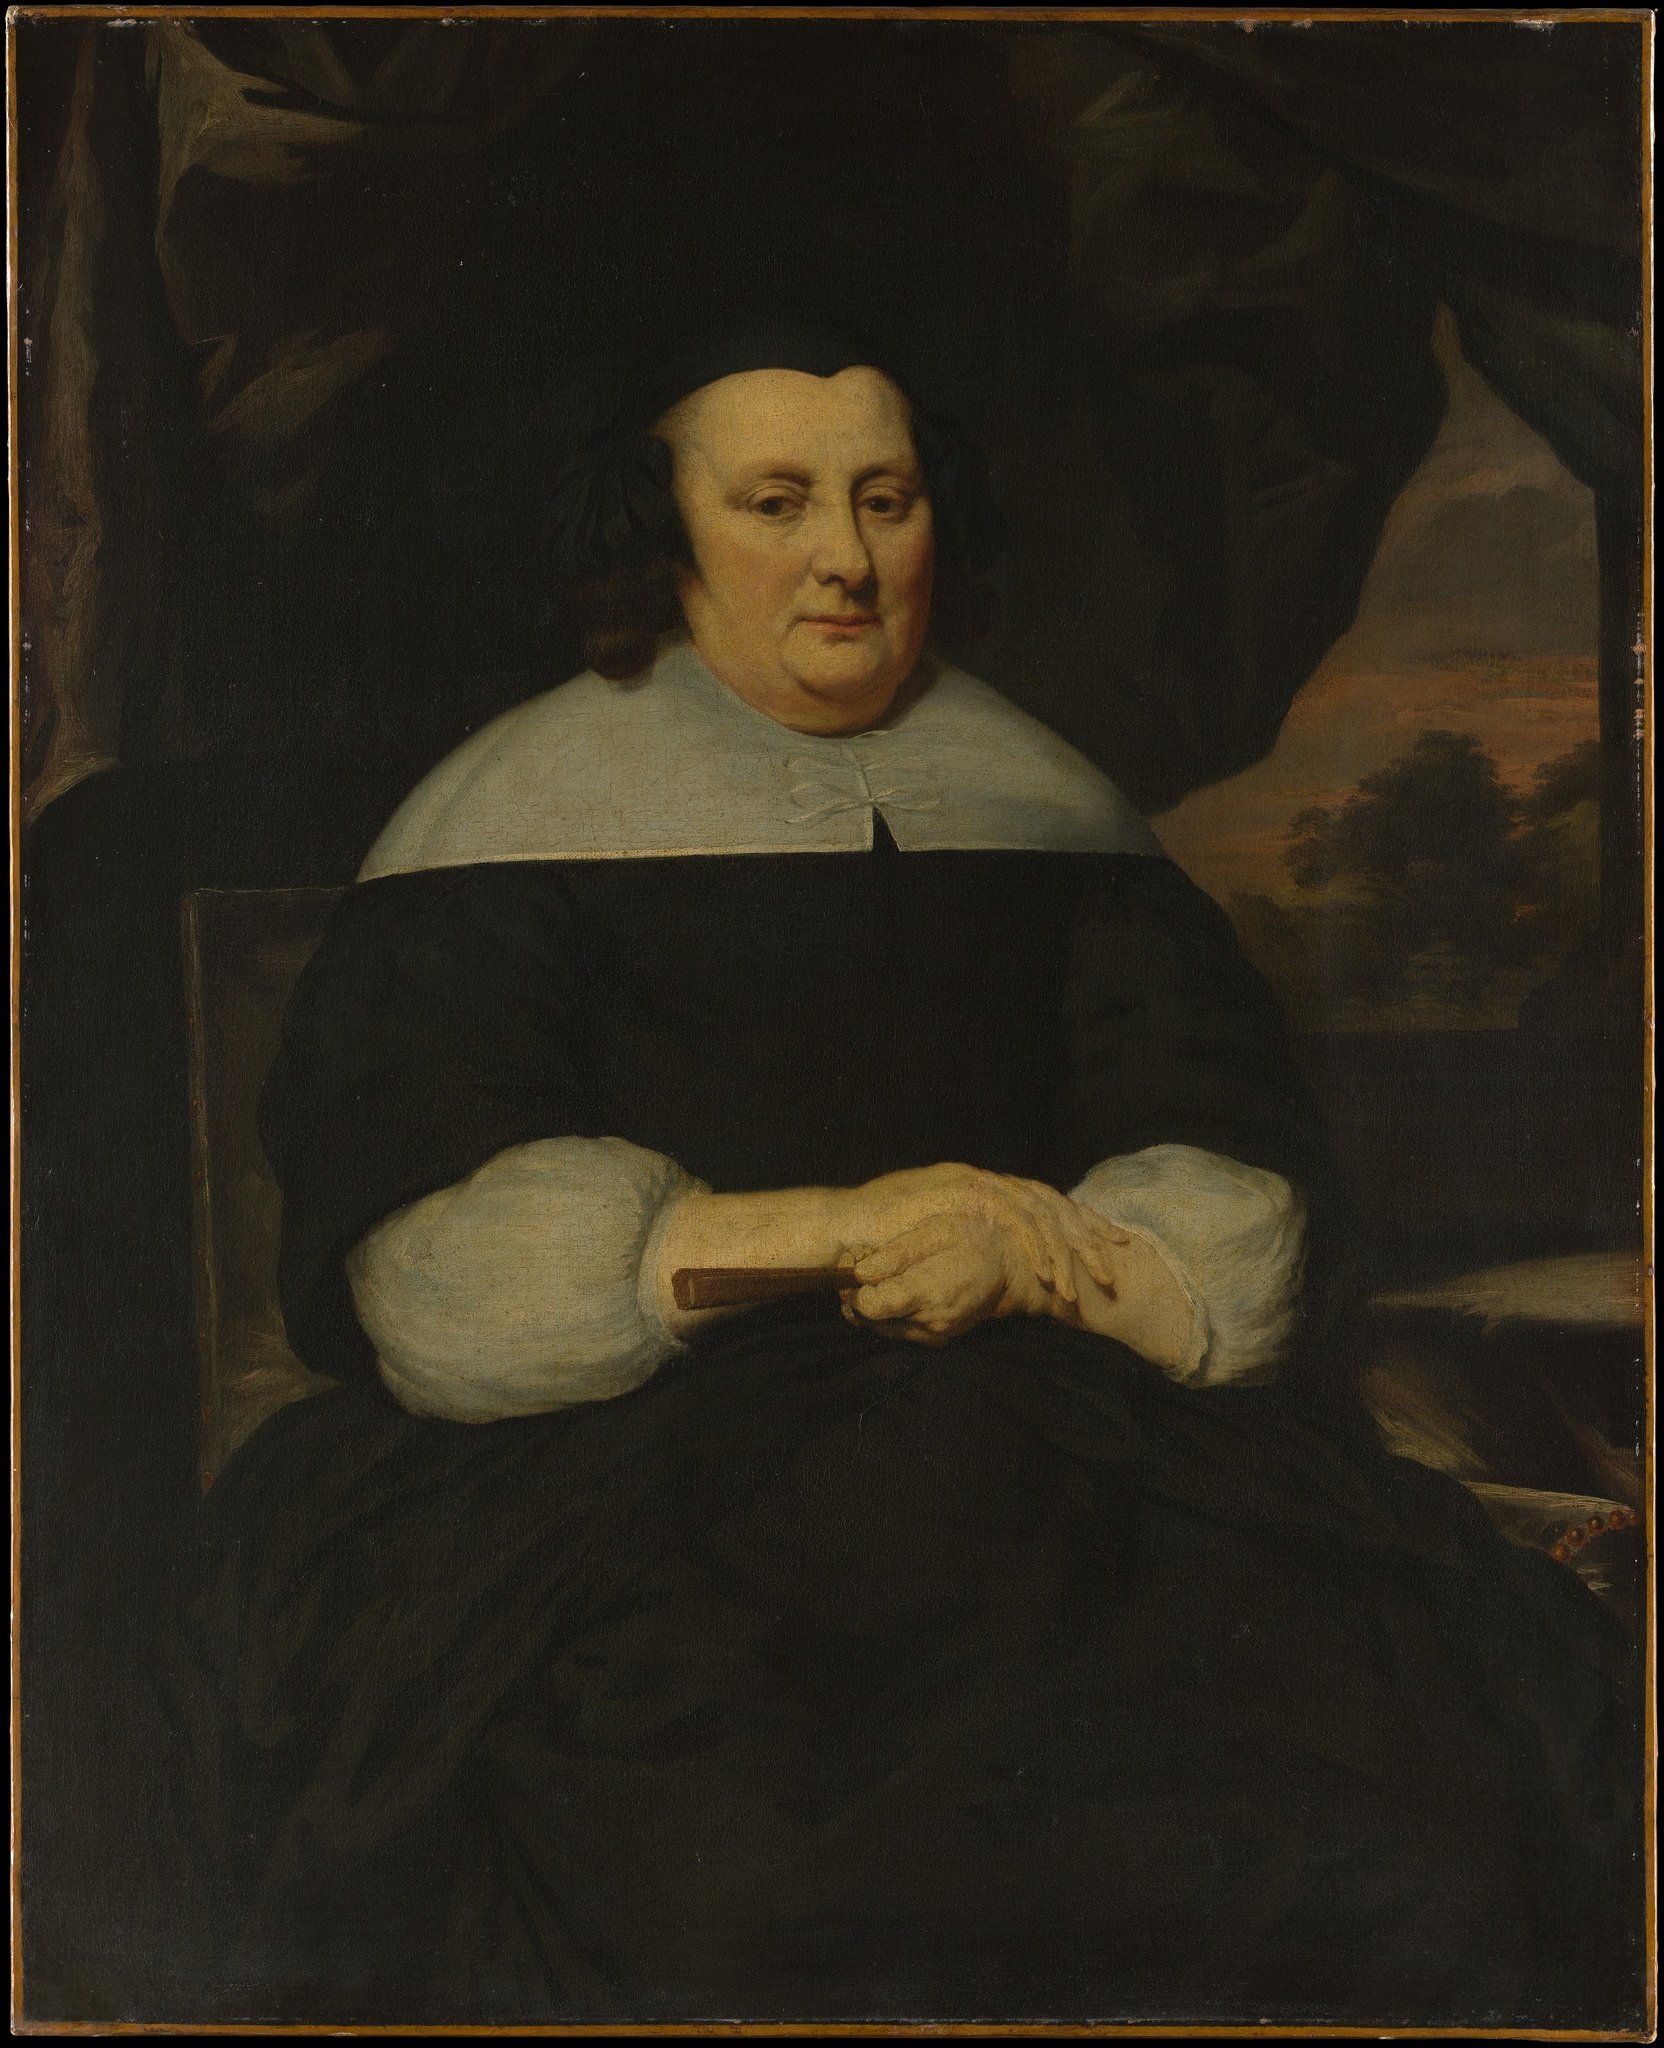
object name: painting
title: Portrait of a Woman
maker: nicolaes maes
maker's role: artist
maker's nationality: dutch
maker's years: 1634-1693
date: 1665-1670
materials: canvas, oil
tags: portraits,women